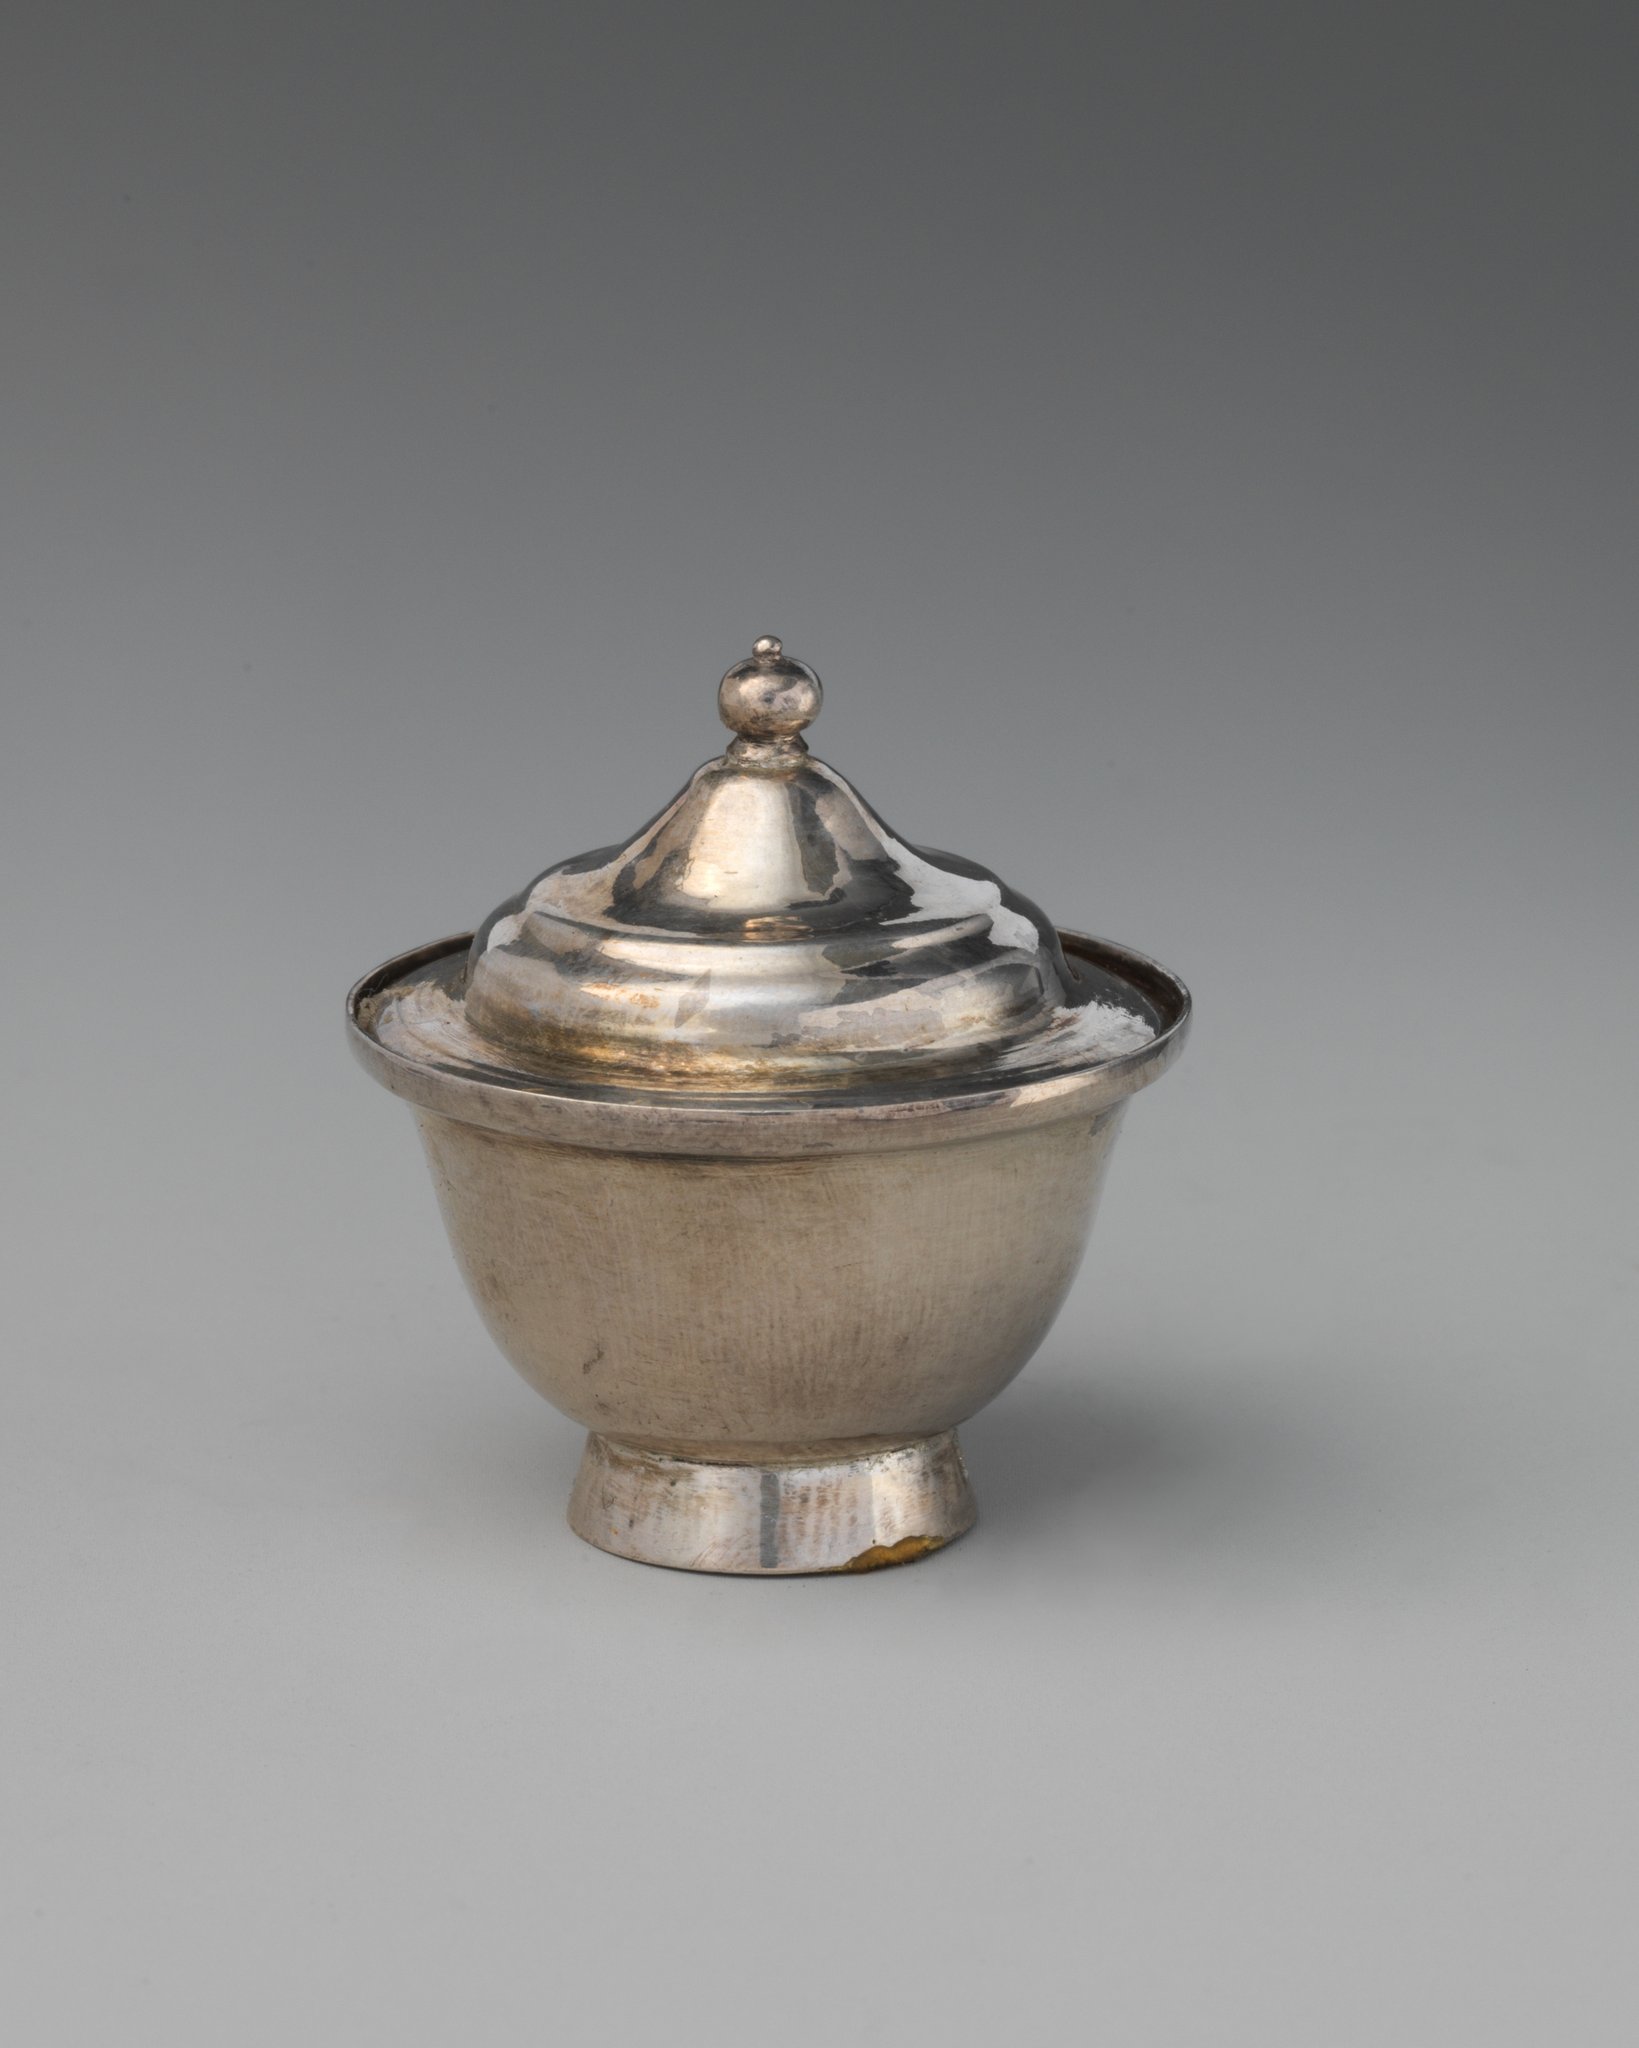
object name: sugar bowl with cover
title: Miniature sugar bowl with cover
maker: david clayton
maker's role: artist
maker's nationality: british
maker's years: 1659-1719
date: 1720-1730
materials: silver